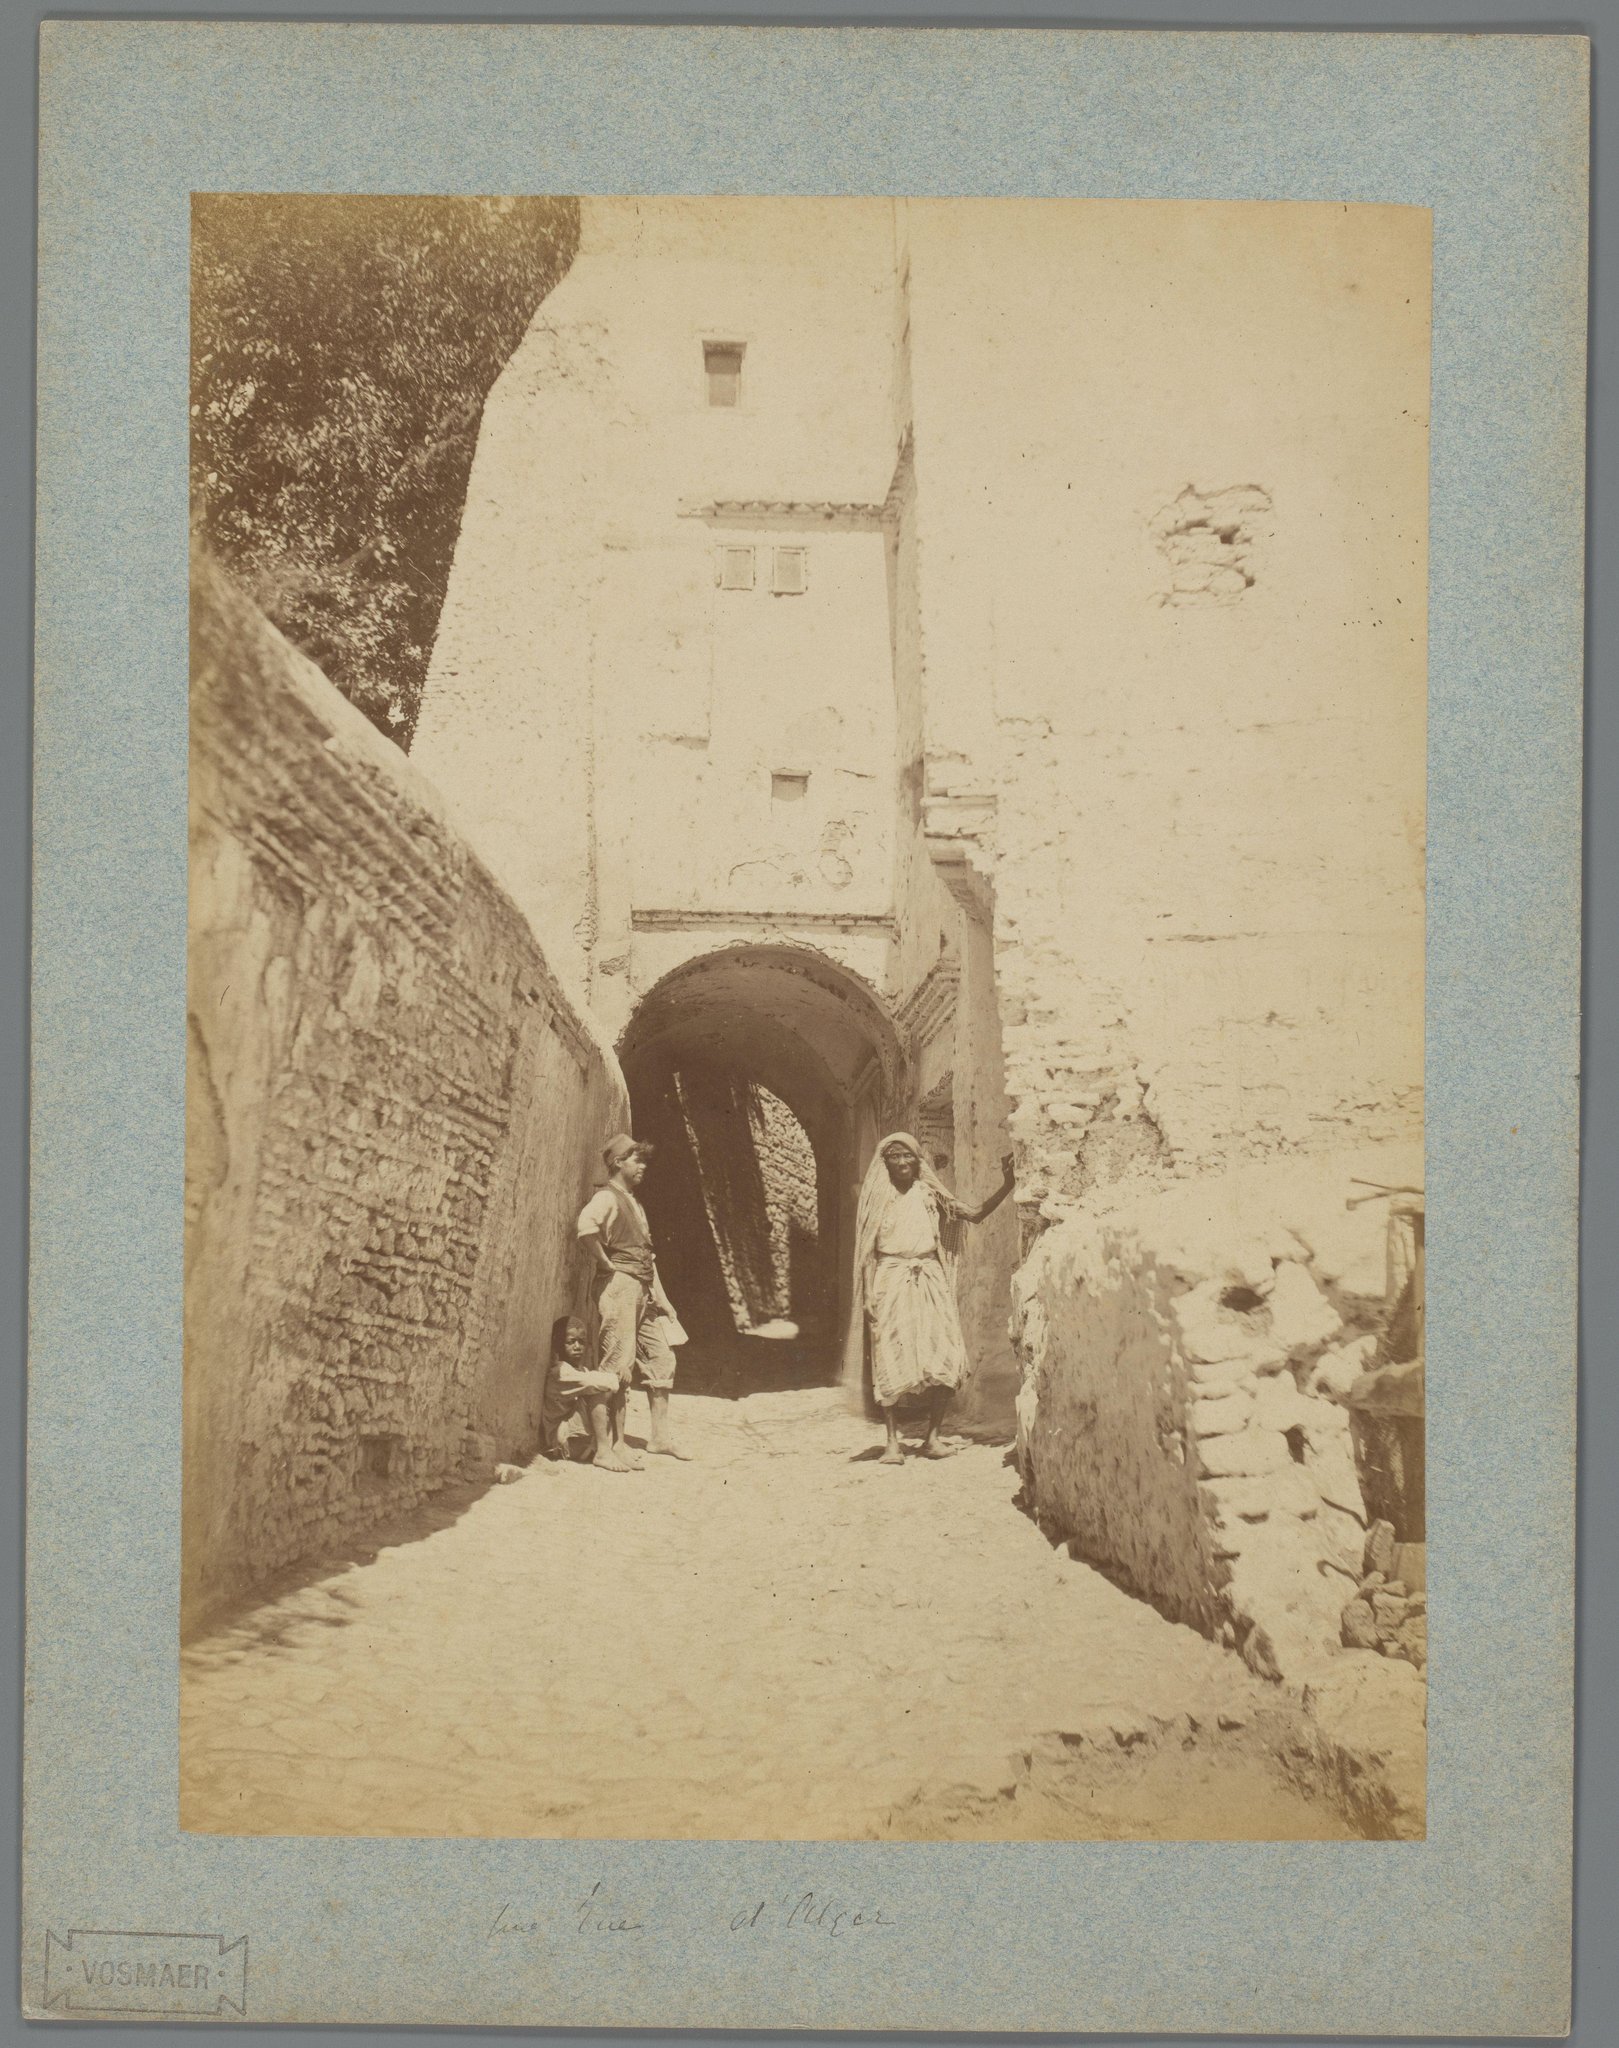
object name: photograph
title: Straatgezicht in Algiers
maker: Anonymous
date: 1851-1900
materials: cardboard, paper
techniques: albumen print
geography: algiers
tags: street (+ city(-scape) with figures, staffage)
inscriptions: inscription: ‘Vue rue d'Alger’, collector's mark: ‘VOSMAER’